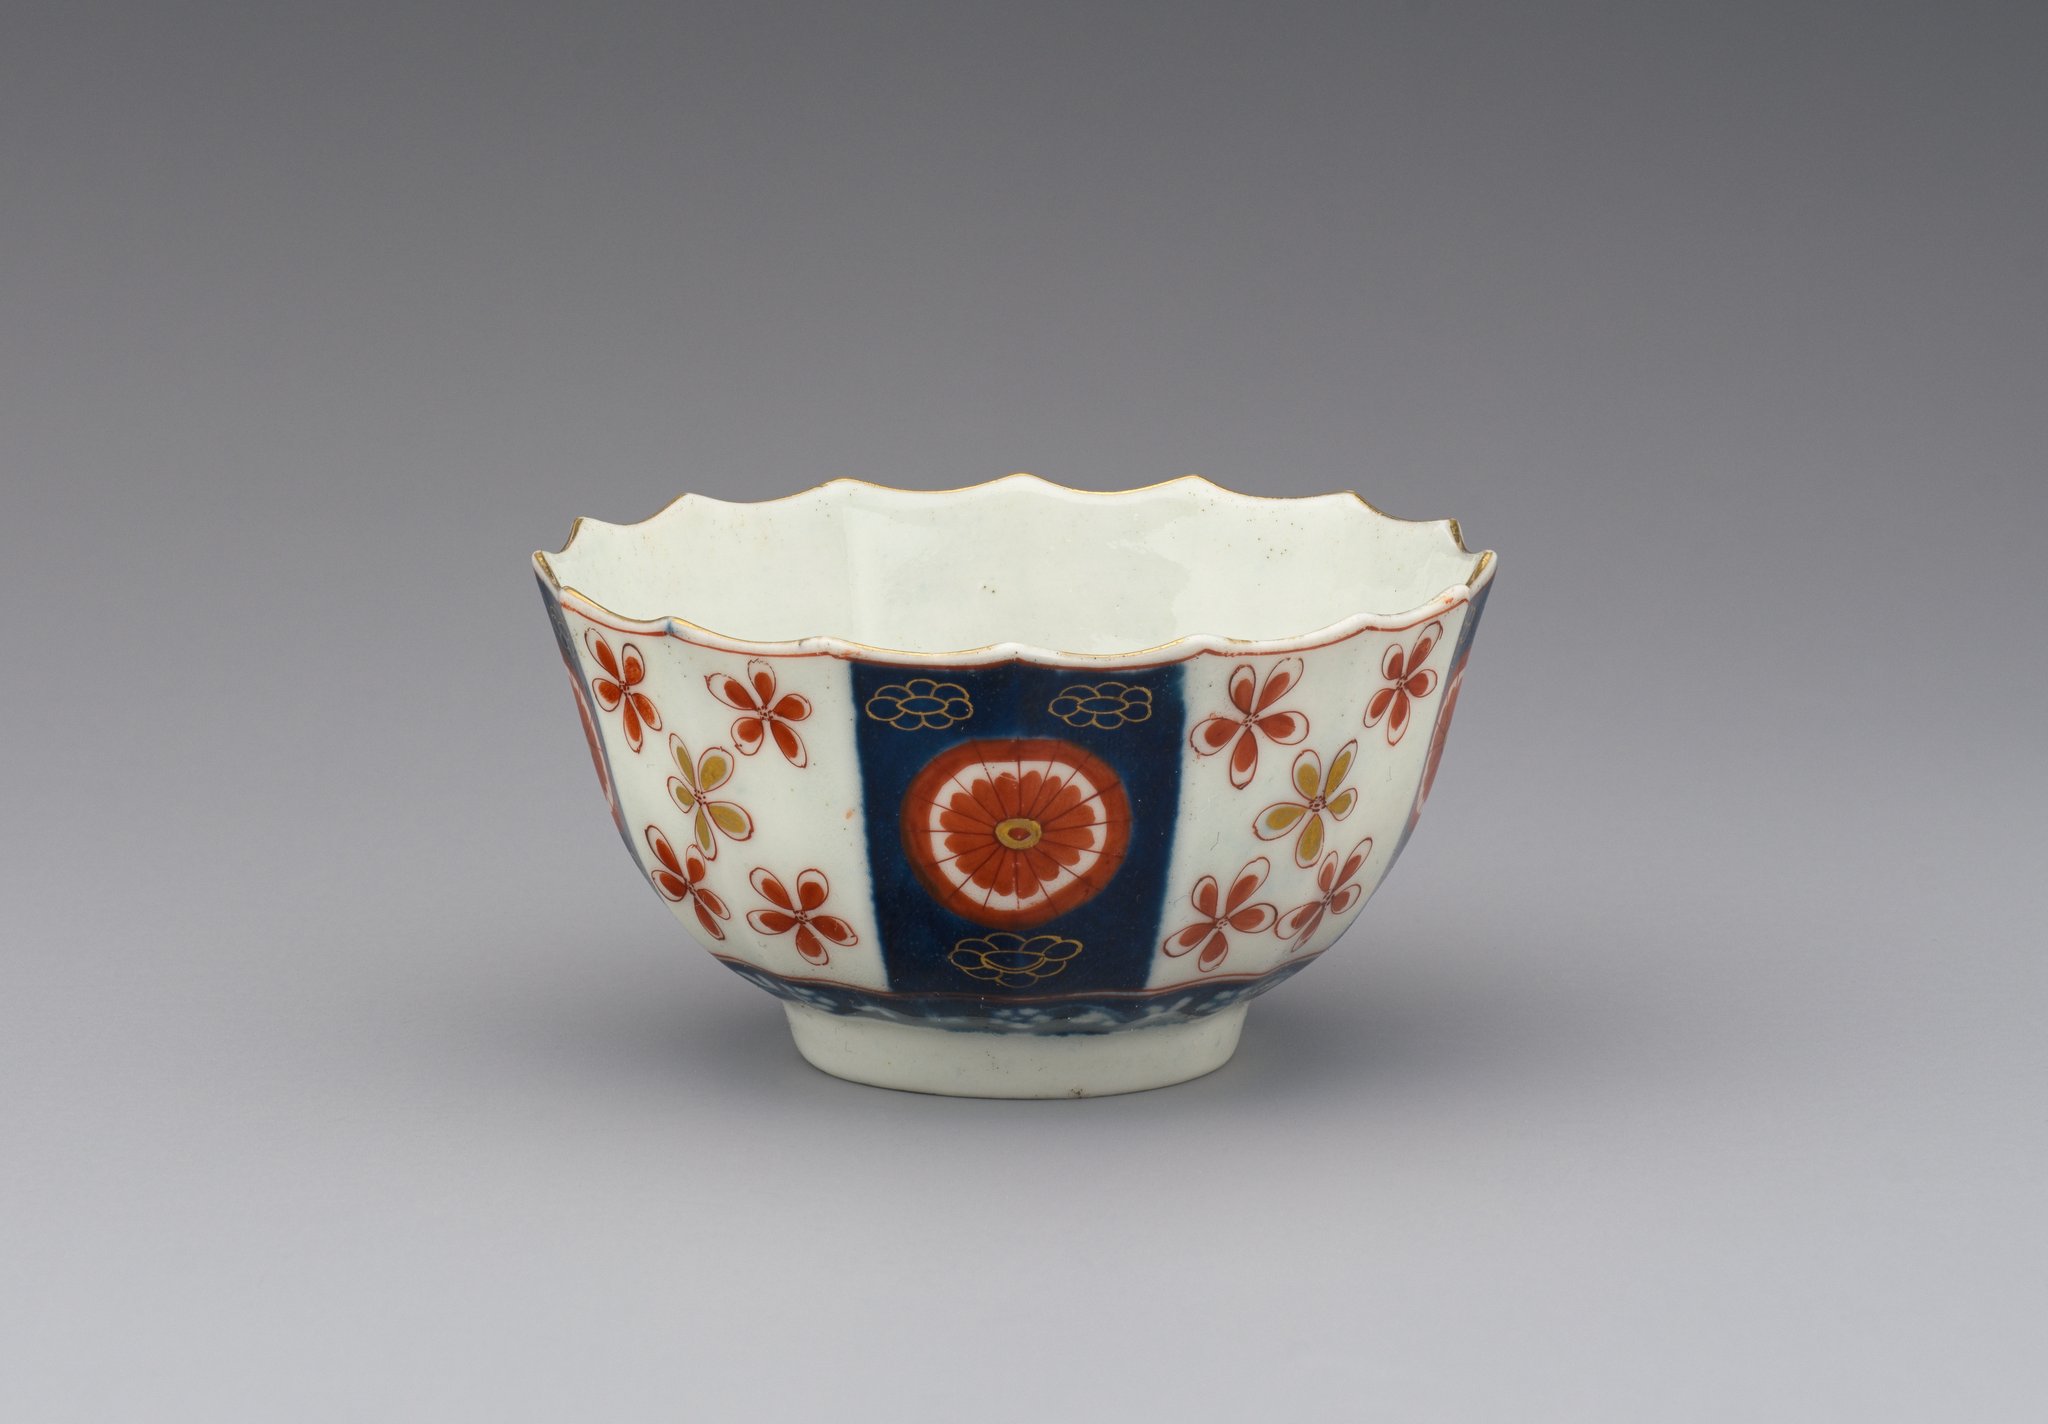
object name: cup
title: Cup (part of a service)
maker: worcester factory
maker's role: factory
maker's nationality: british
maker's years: 1751-2008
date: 1765-1775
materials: soft paste porcelain